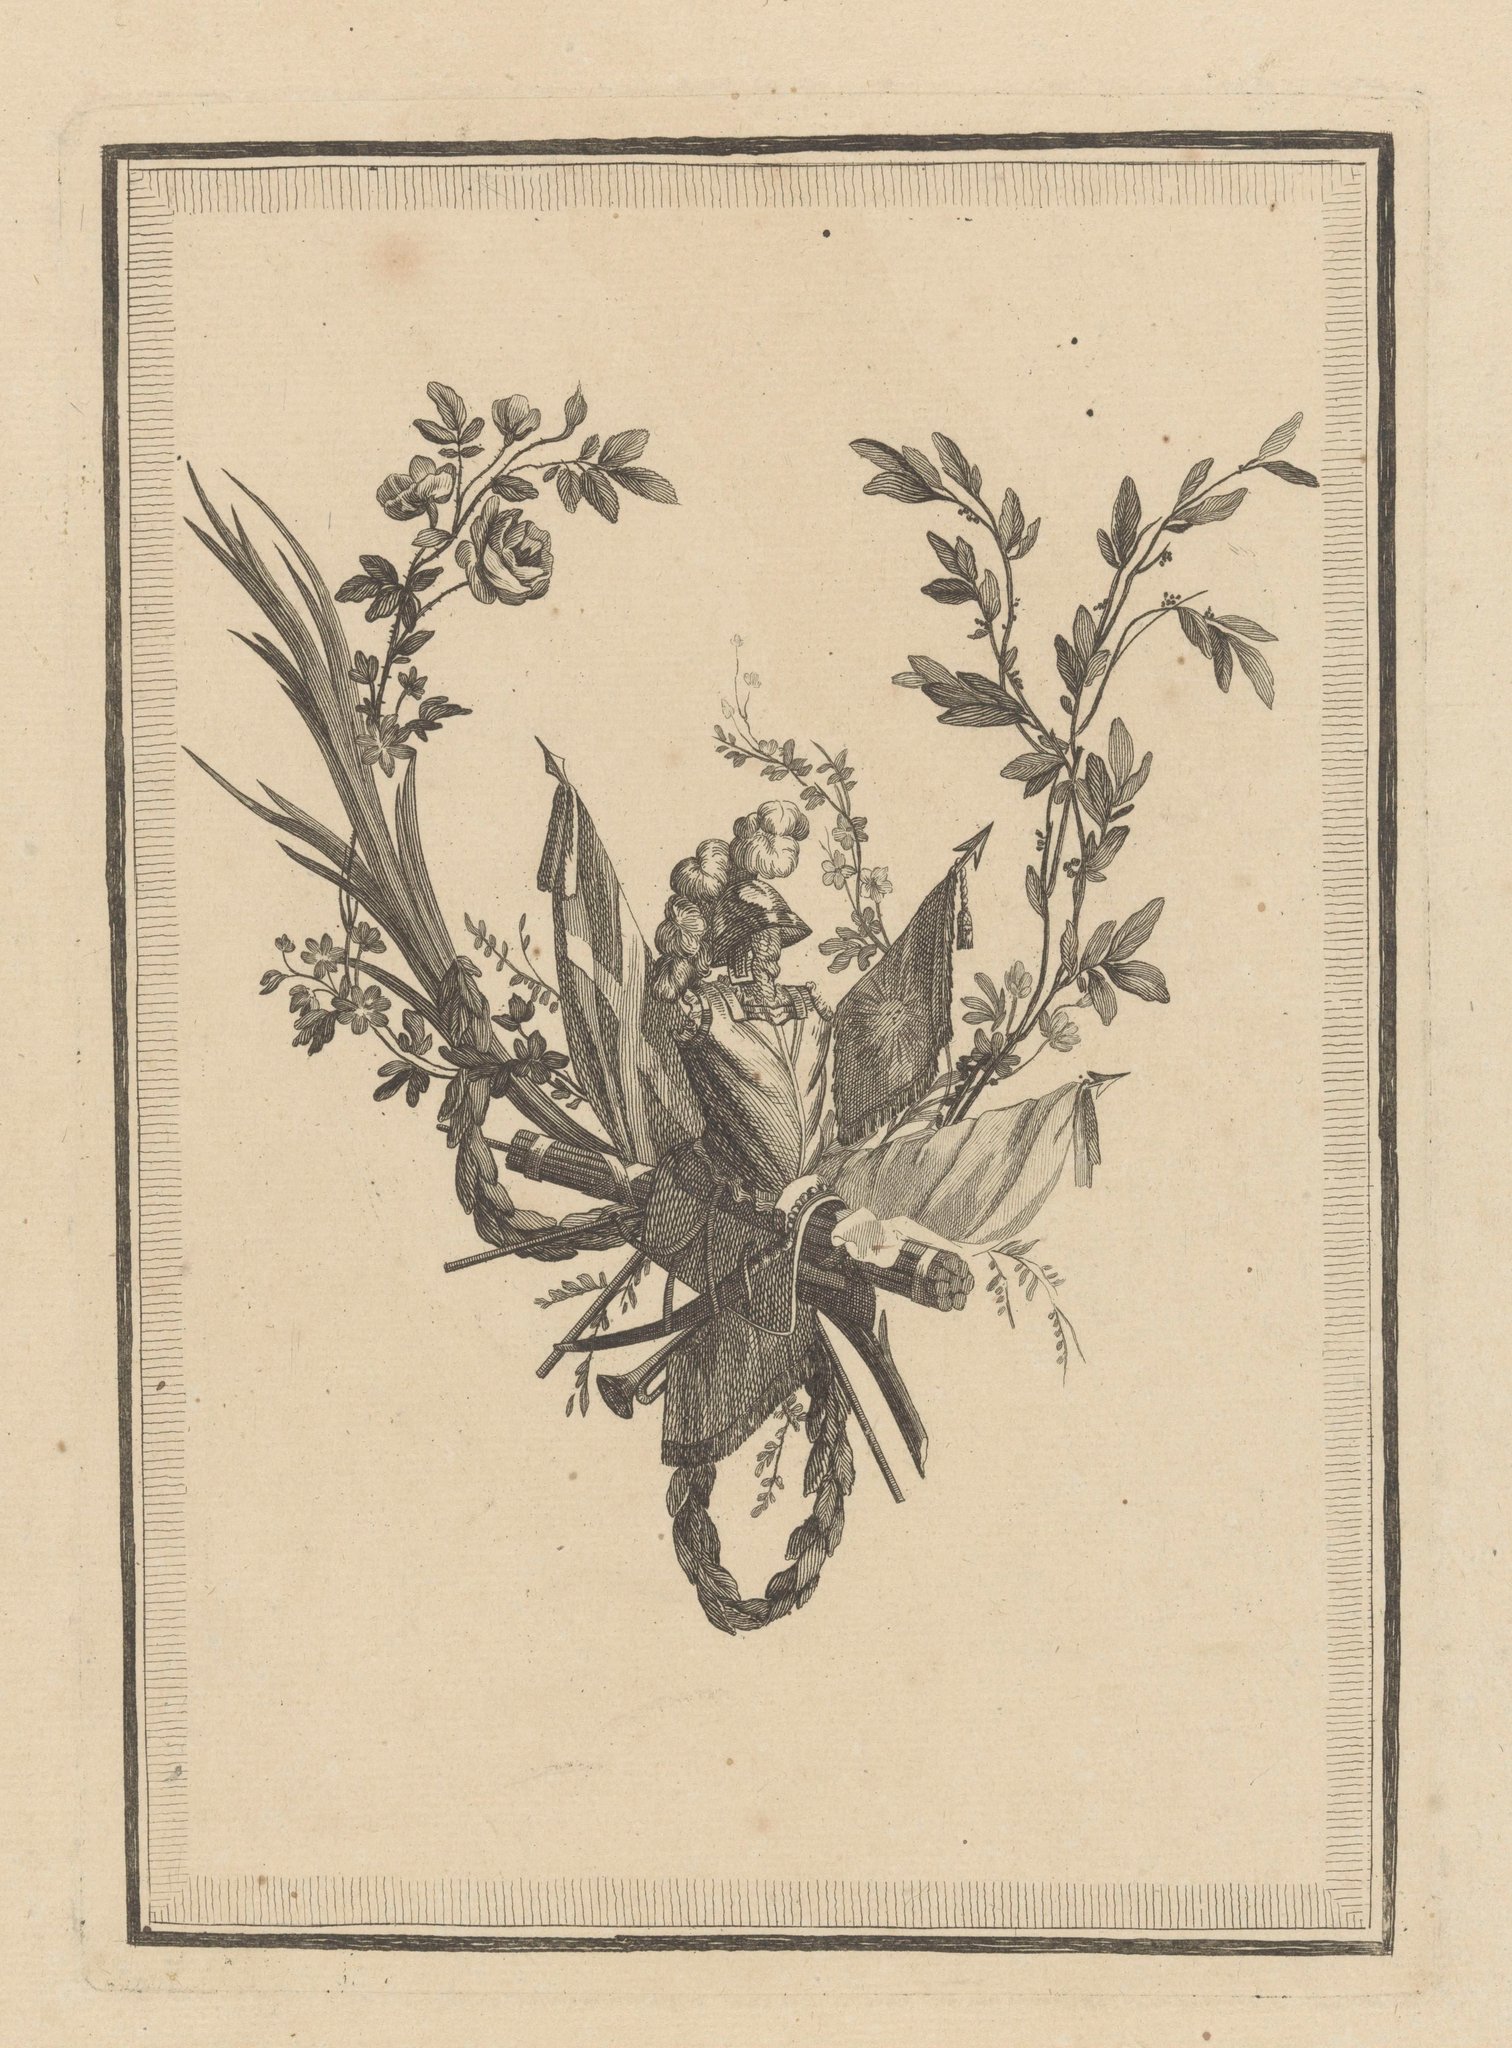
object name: print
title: Trofee met wapens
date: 1760-1784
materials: paper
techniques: etching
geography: paris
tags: trophy, i.e.: decorative arrangement of symbolic or typical objects ~ ornament, weapons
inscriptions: collector's mark: Lugt 2228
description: Een trofee met bloemen, vlaggen, een harnas en wapens.